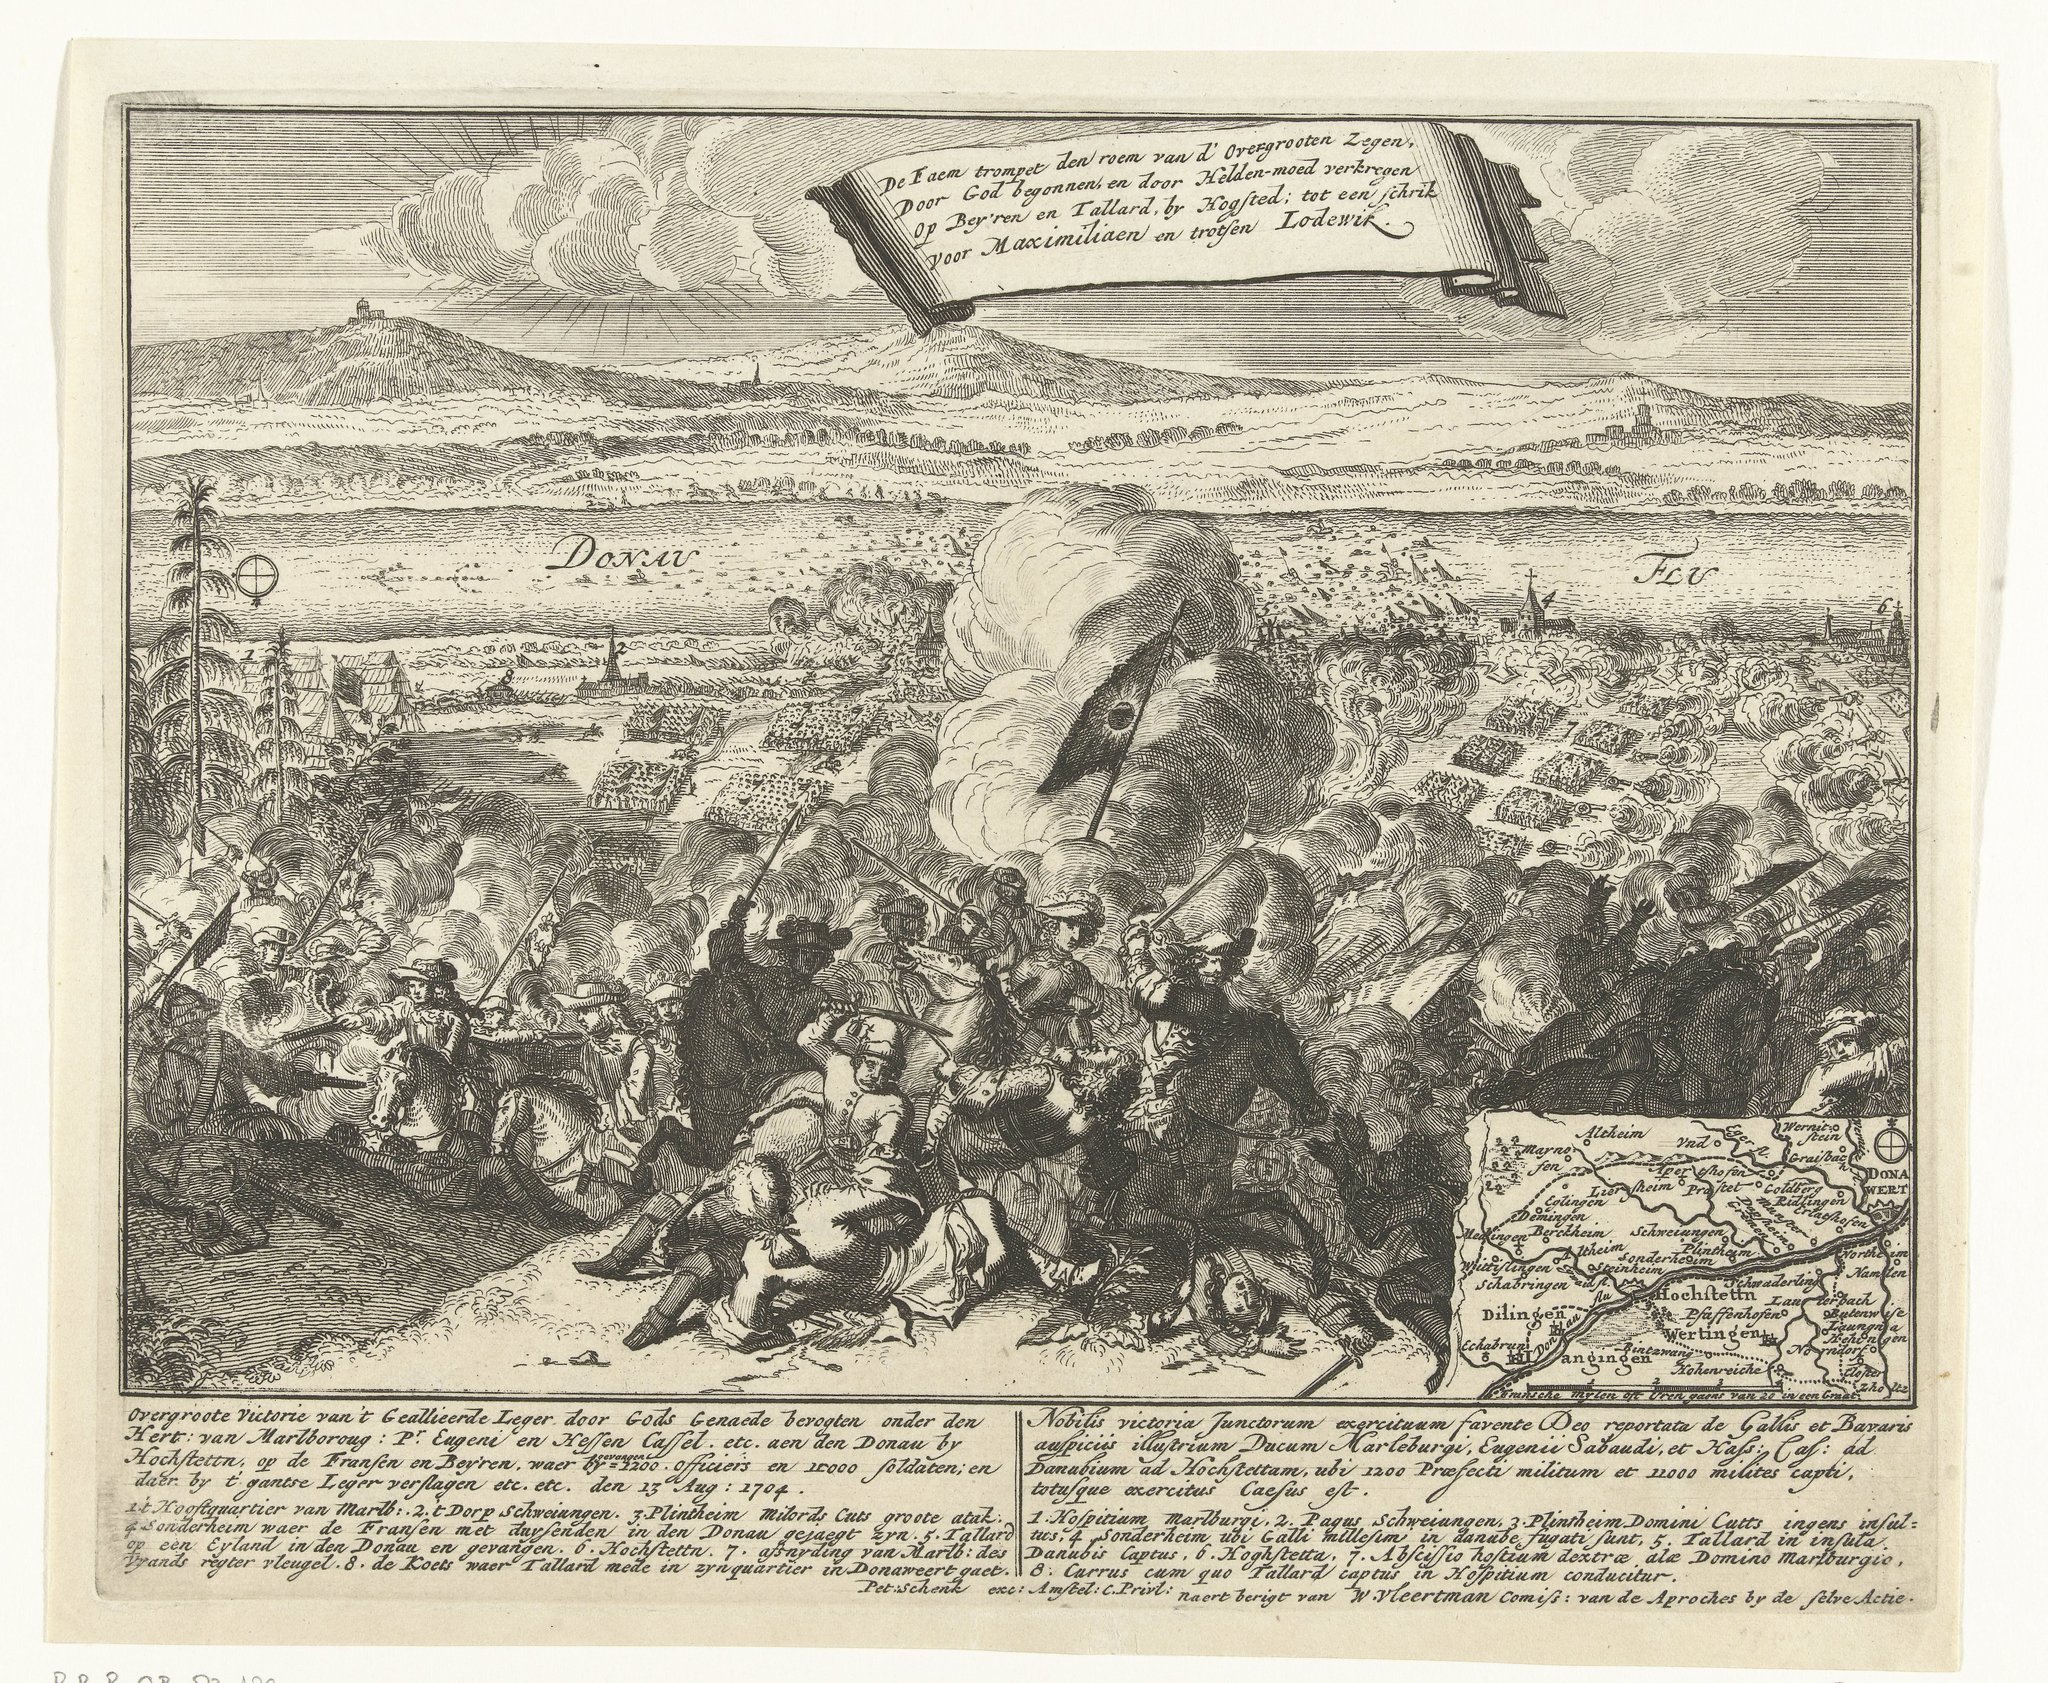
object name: print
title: Slag bij Höchstädt, 1704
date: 1704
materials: paper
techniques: etching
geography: amsterdam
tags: paris, vienna, eugenius van savoye, john churchill (1e hertog van marlborough), battle (+ land forces)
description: De slag bij Höchstädt (slag bij Blenheim) met een overwinning van de Geallieerden op de Fransen, 13 augustus 1704. Rechtsonder een inzet met een kaartje van het groter gebied. In het onderschrift de titels en legenda's in het Nederlands en Latijn.